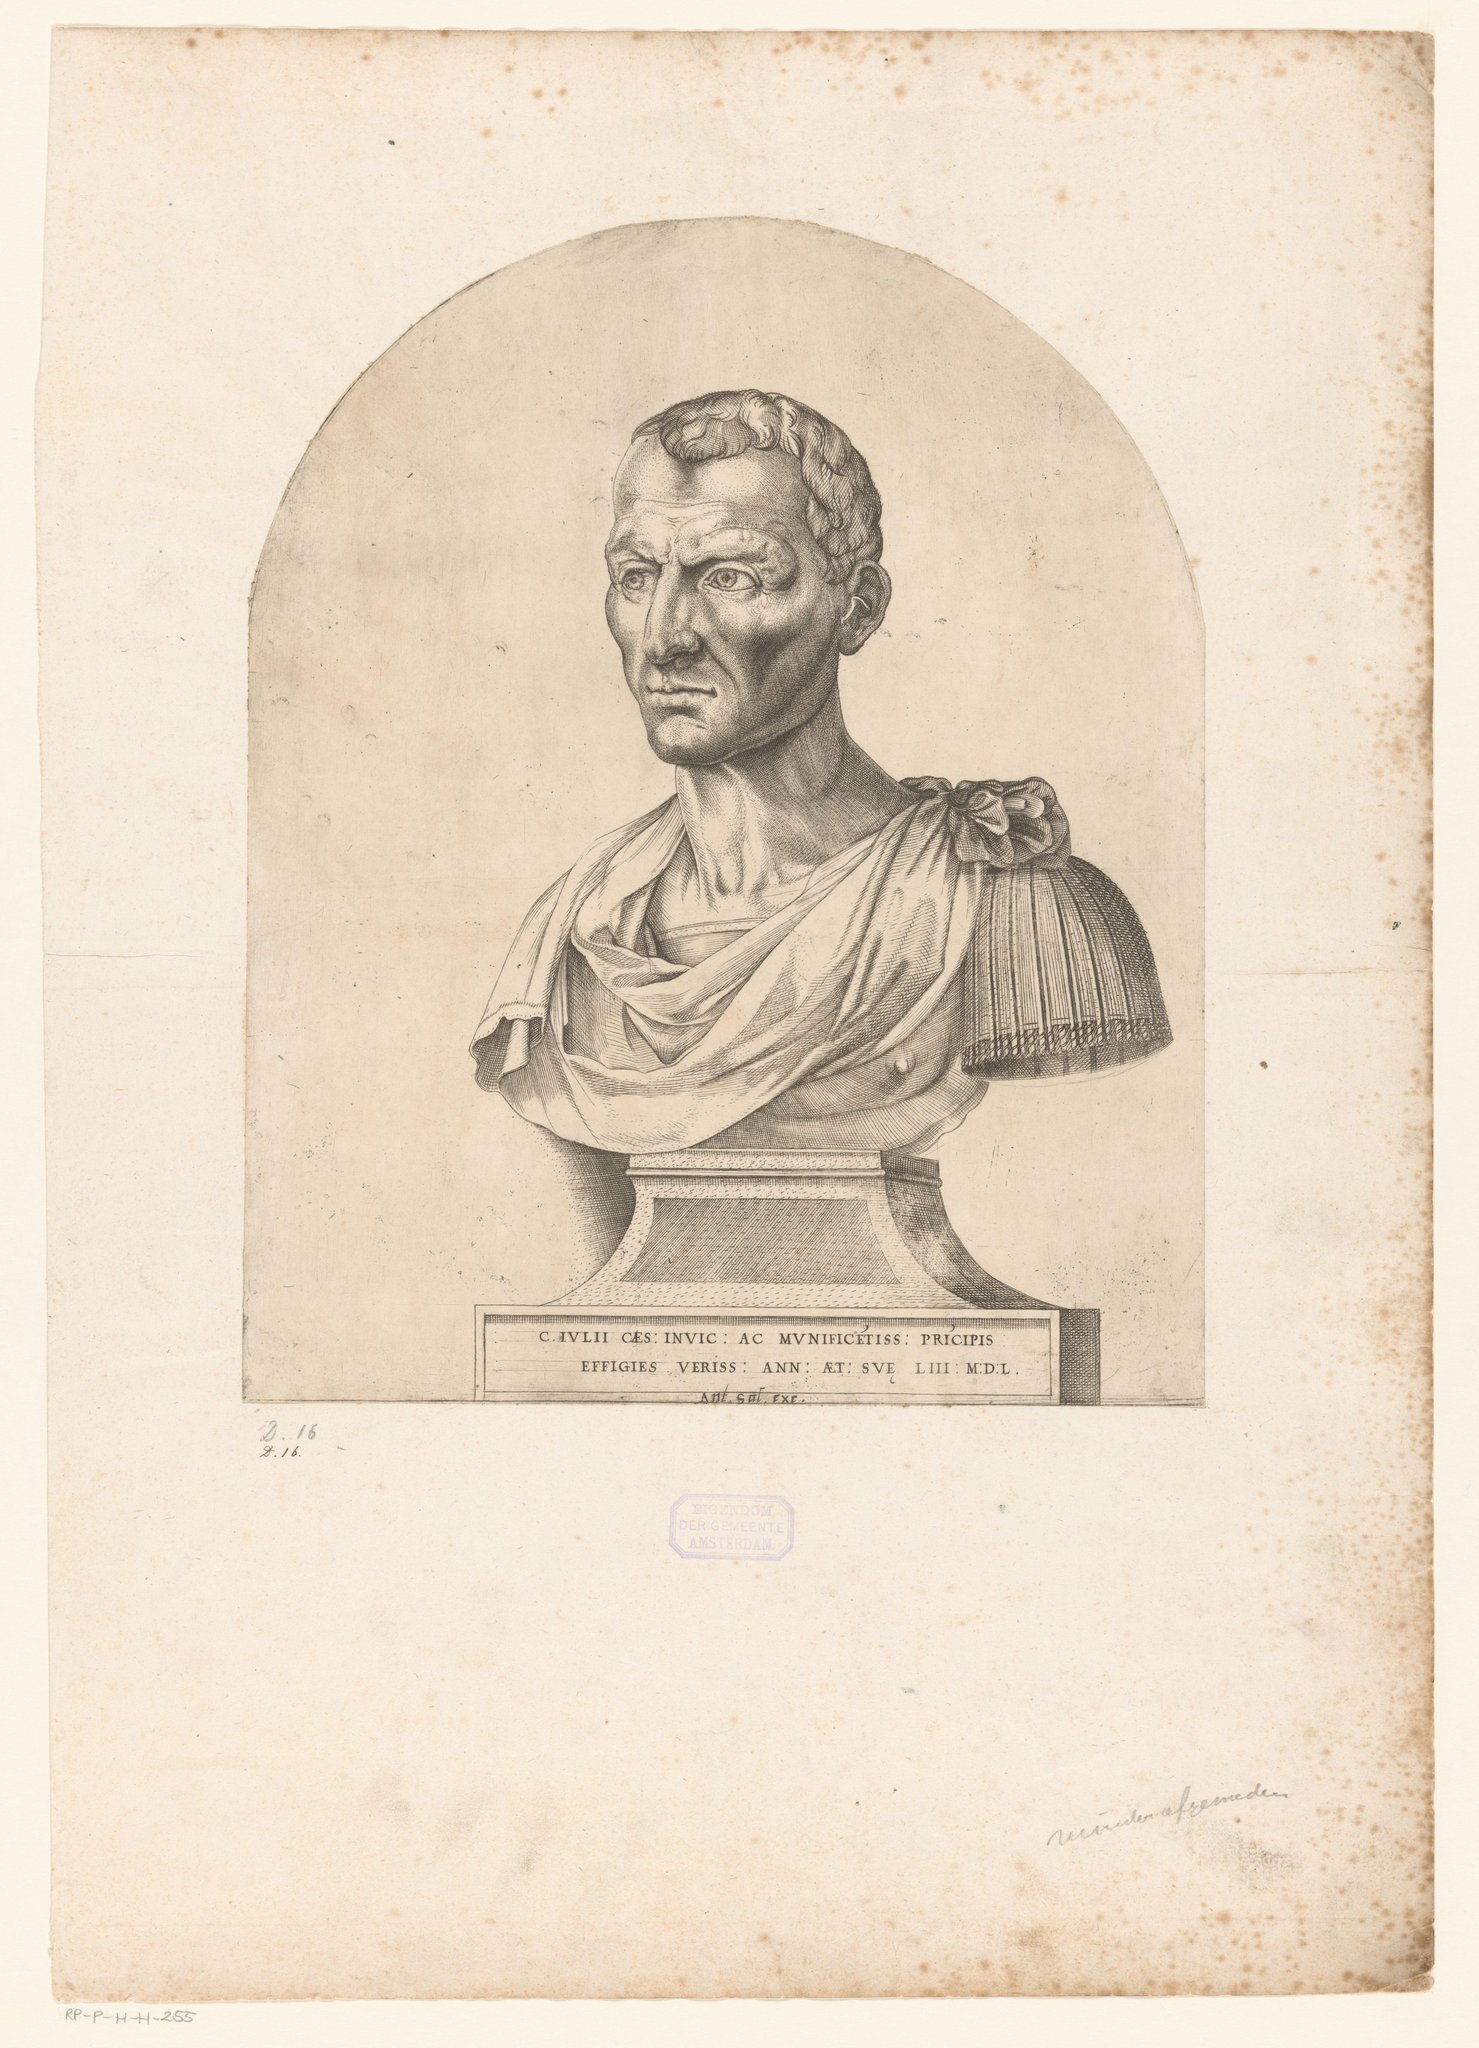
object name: print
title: Portretbuste van Julius Caesar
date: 1550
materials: paper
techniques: engraving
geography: italy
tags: rome, historical persons, piece of sculpture, reproduction of a piece of sculpture, ruler, sovereign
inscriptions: collector's mark: Lugt 11